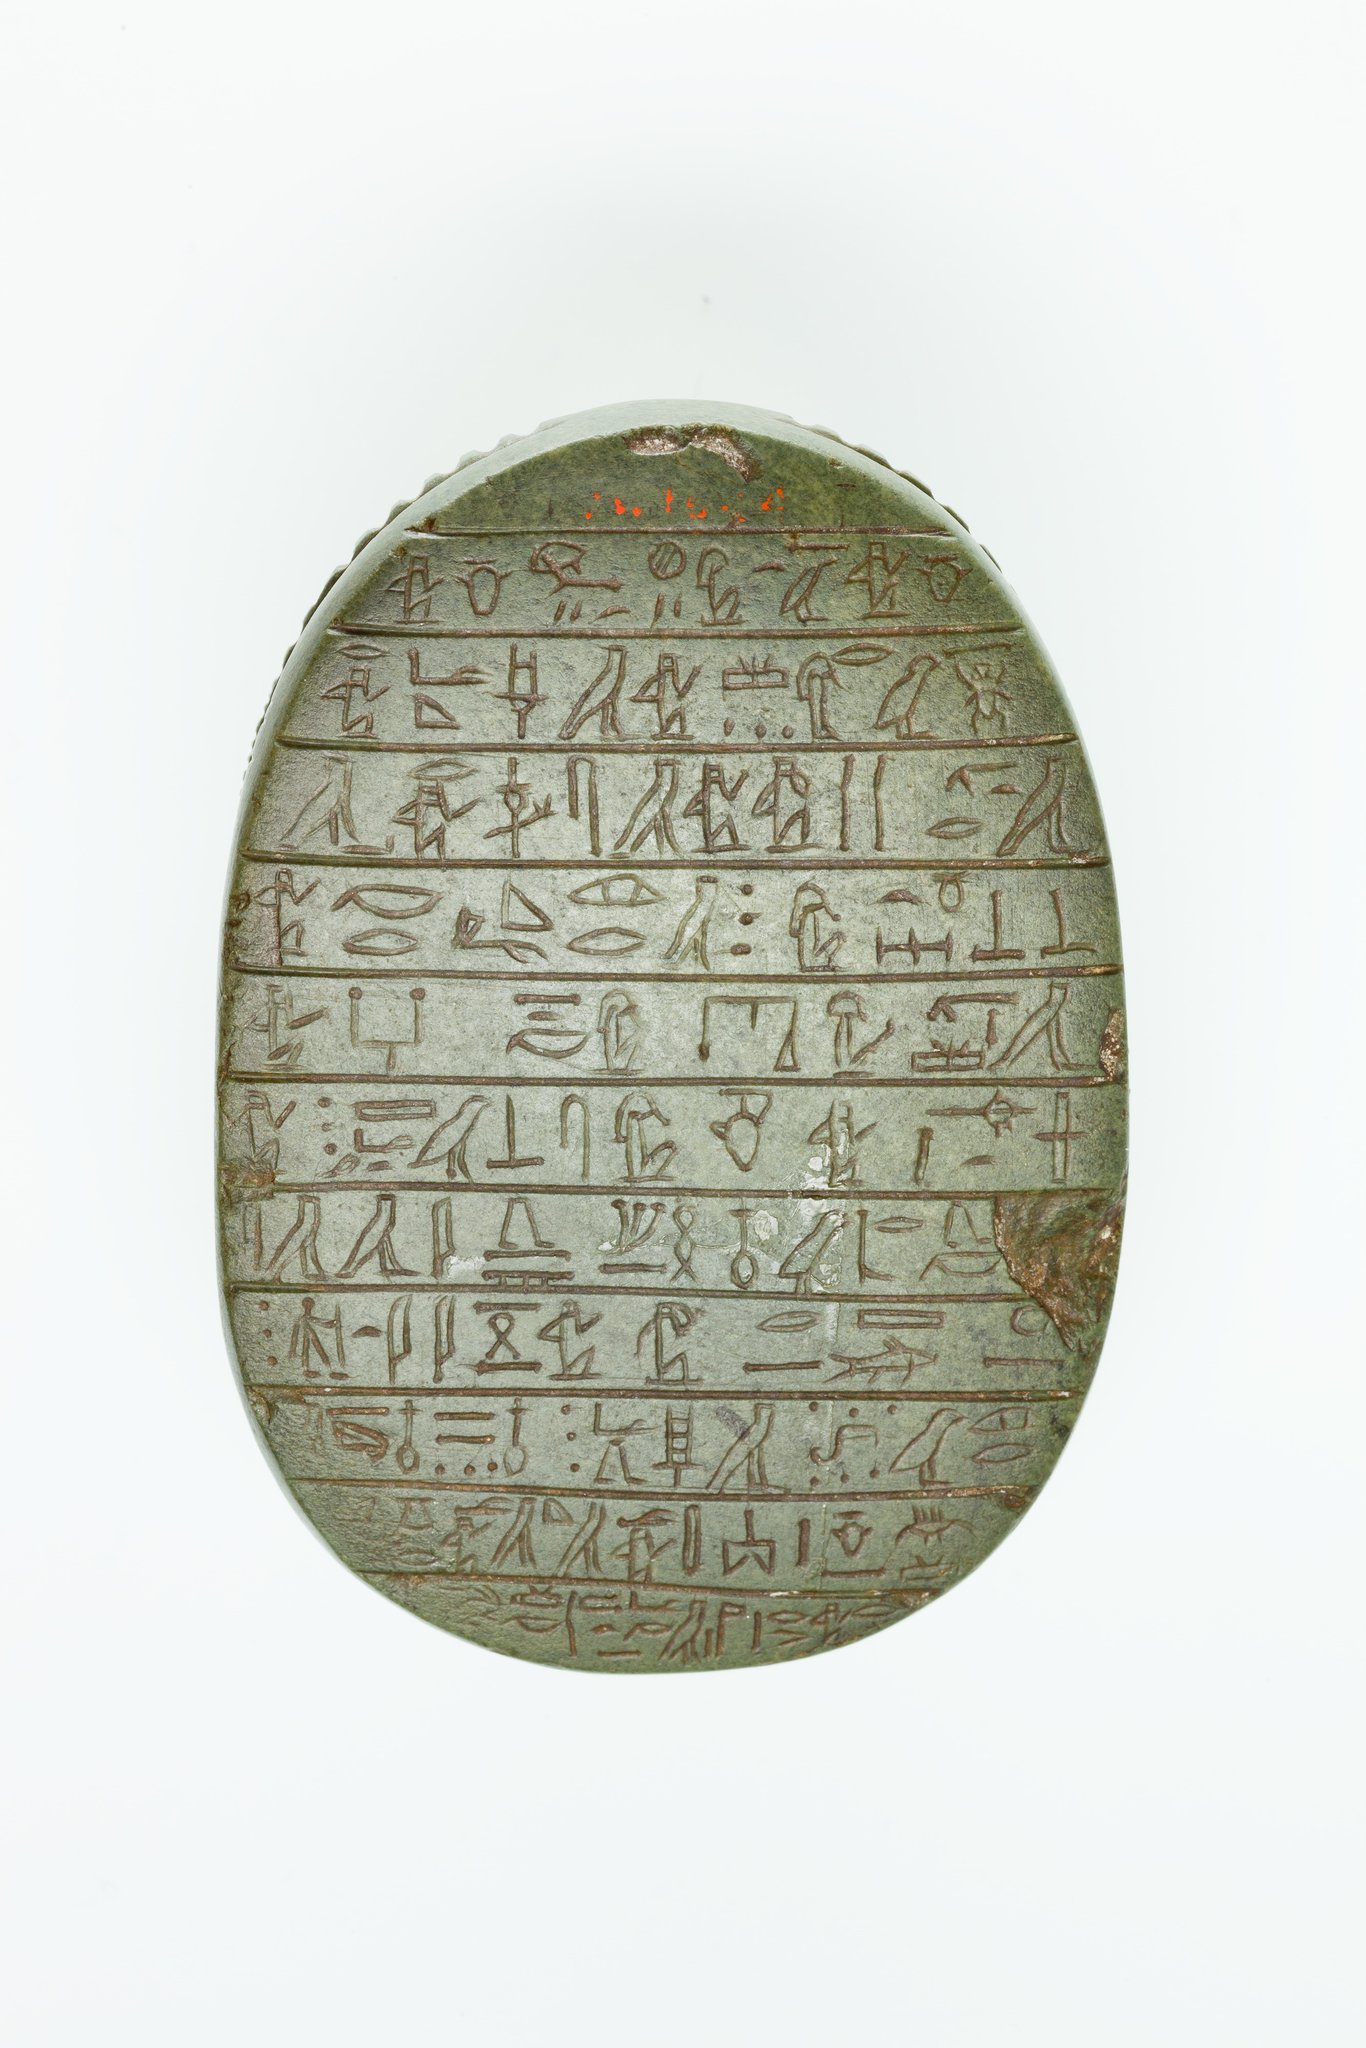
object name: heart scarab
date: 1550-1295 BCE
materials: stone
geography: egypt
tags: hieroglyphs,scarabs